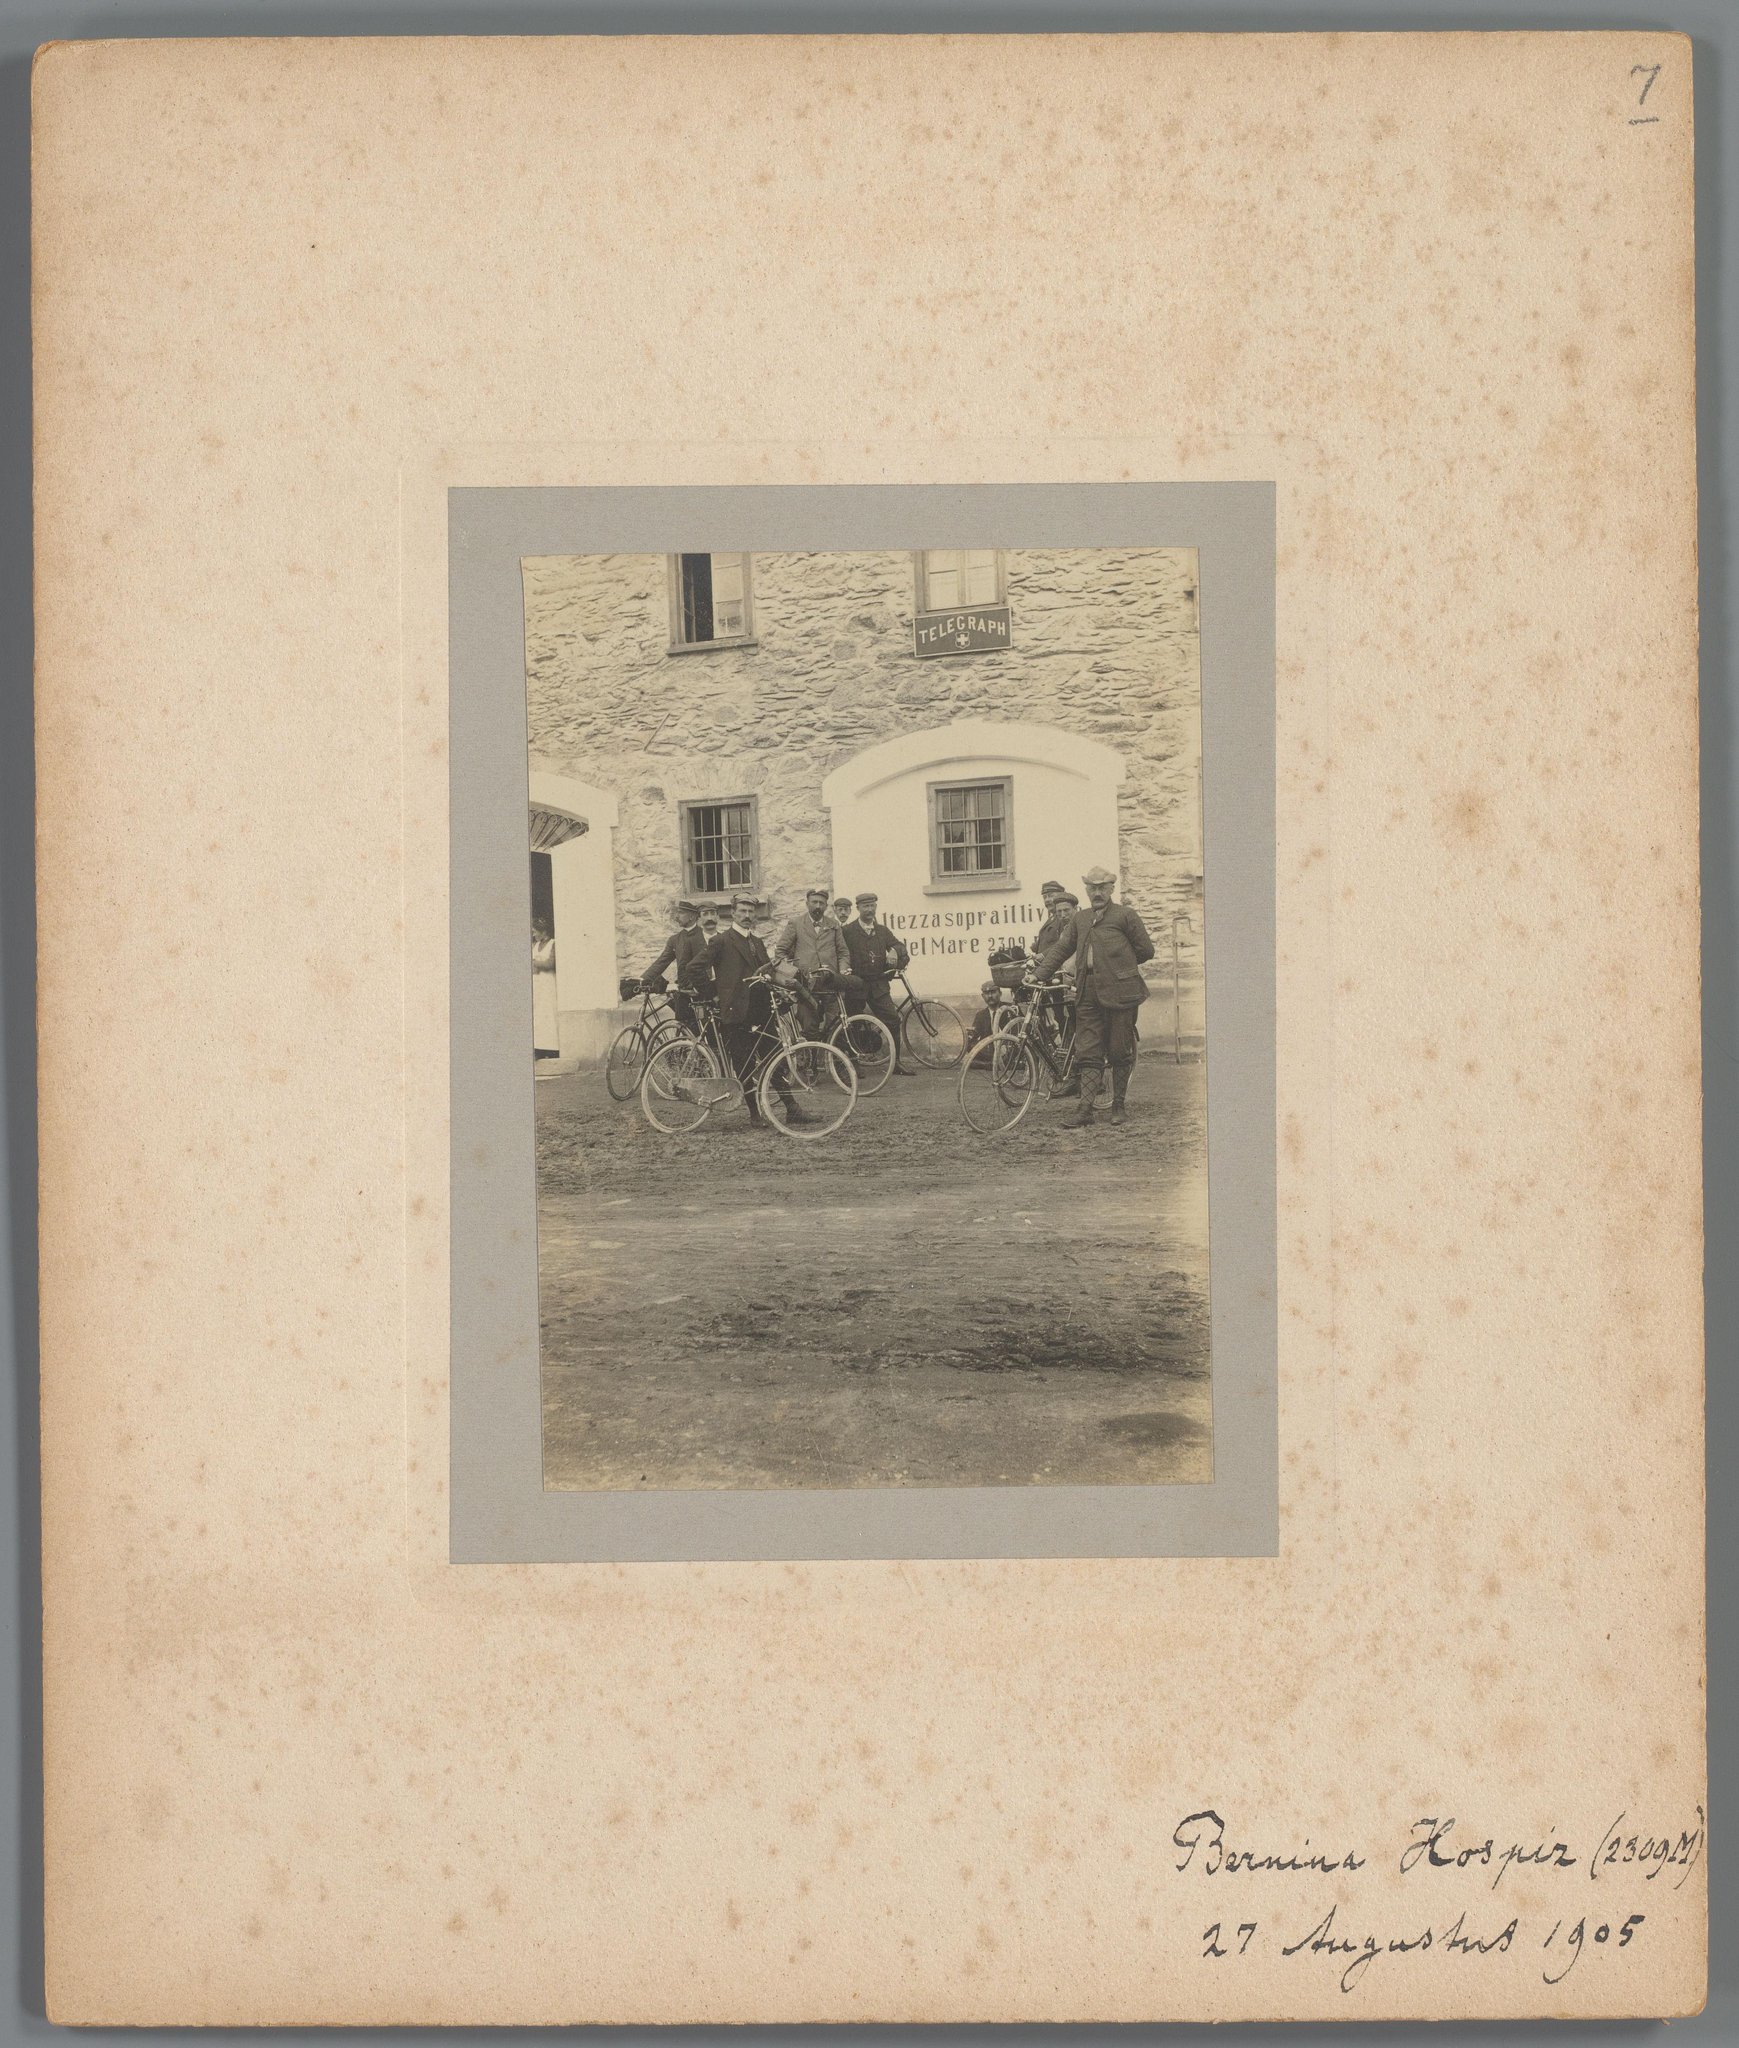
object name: photograph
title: Bernina Hospiz (2309 M)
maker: françois buys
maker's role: advocaat, amateurfotograaf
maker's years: 1871-1934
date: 1905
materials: paper, cardboard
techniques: gelatin silver print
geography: bernina pass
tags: bicycle, anonymous historical persons portrayed in a group, in a group-portrait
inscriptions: number: ‘7’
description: Deze foto maakt deel uit van een groep van 38 foto's.